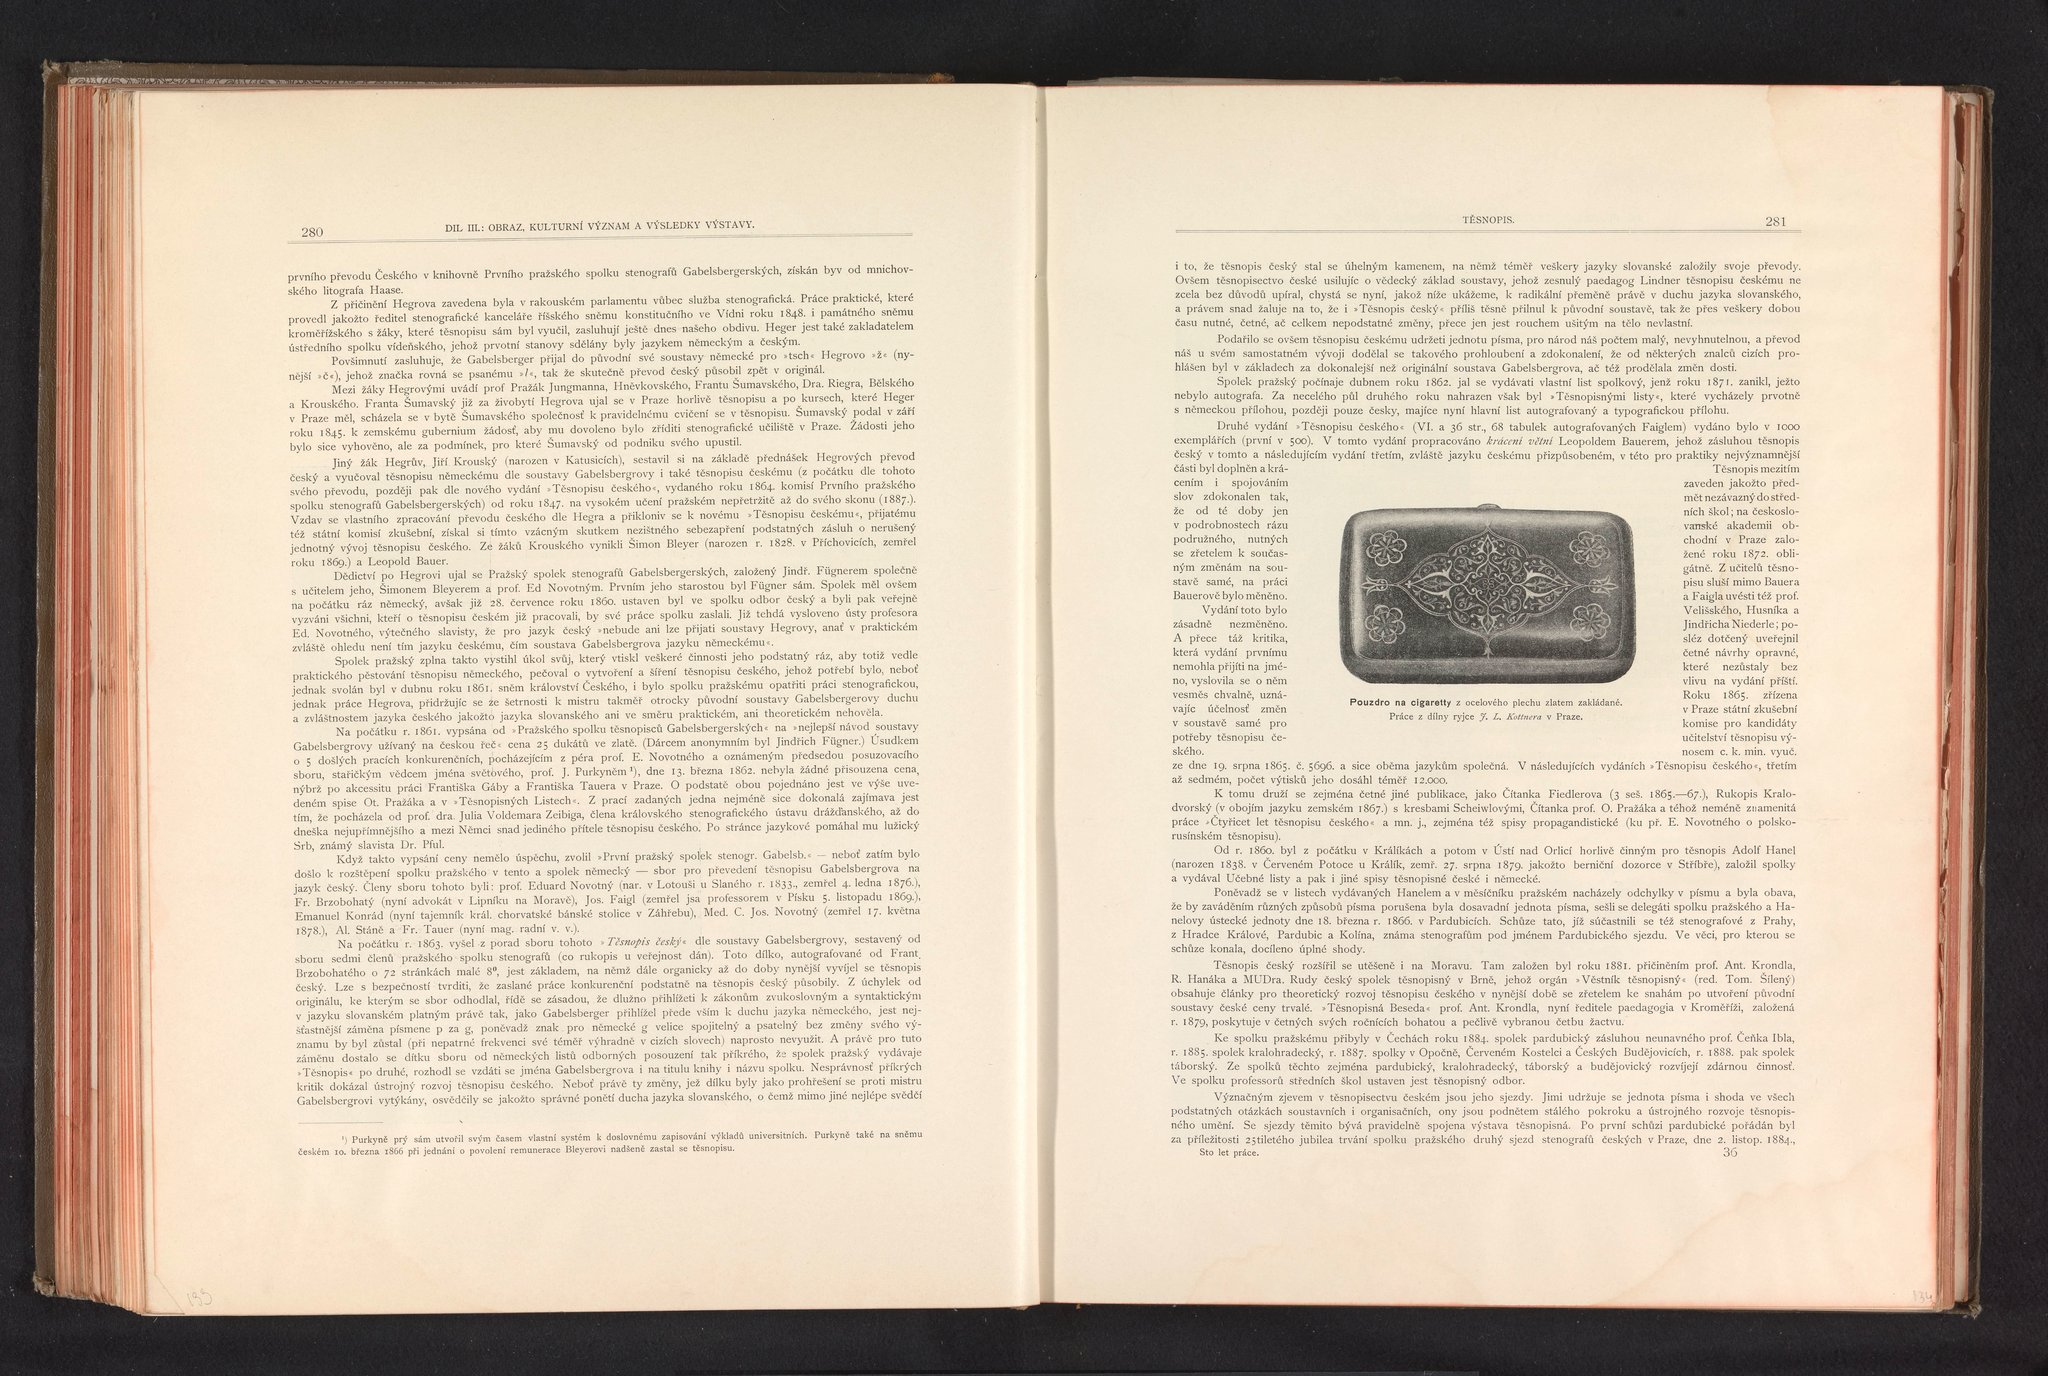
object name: photomechanical print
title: Pouzdro na cigaretty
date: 1890-1895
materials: paper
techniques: autotype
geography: prague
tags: cigarette-case